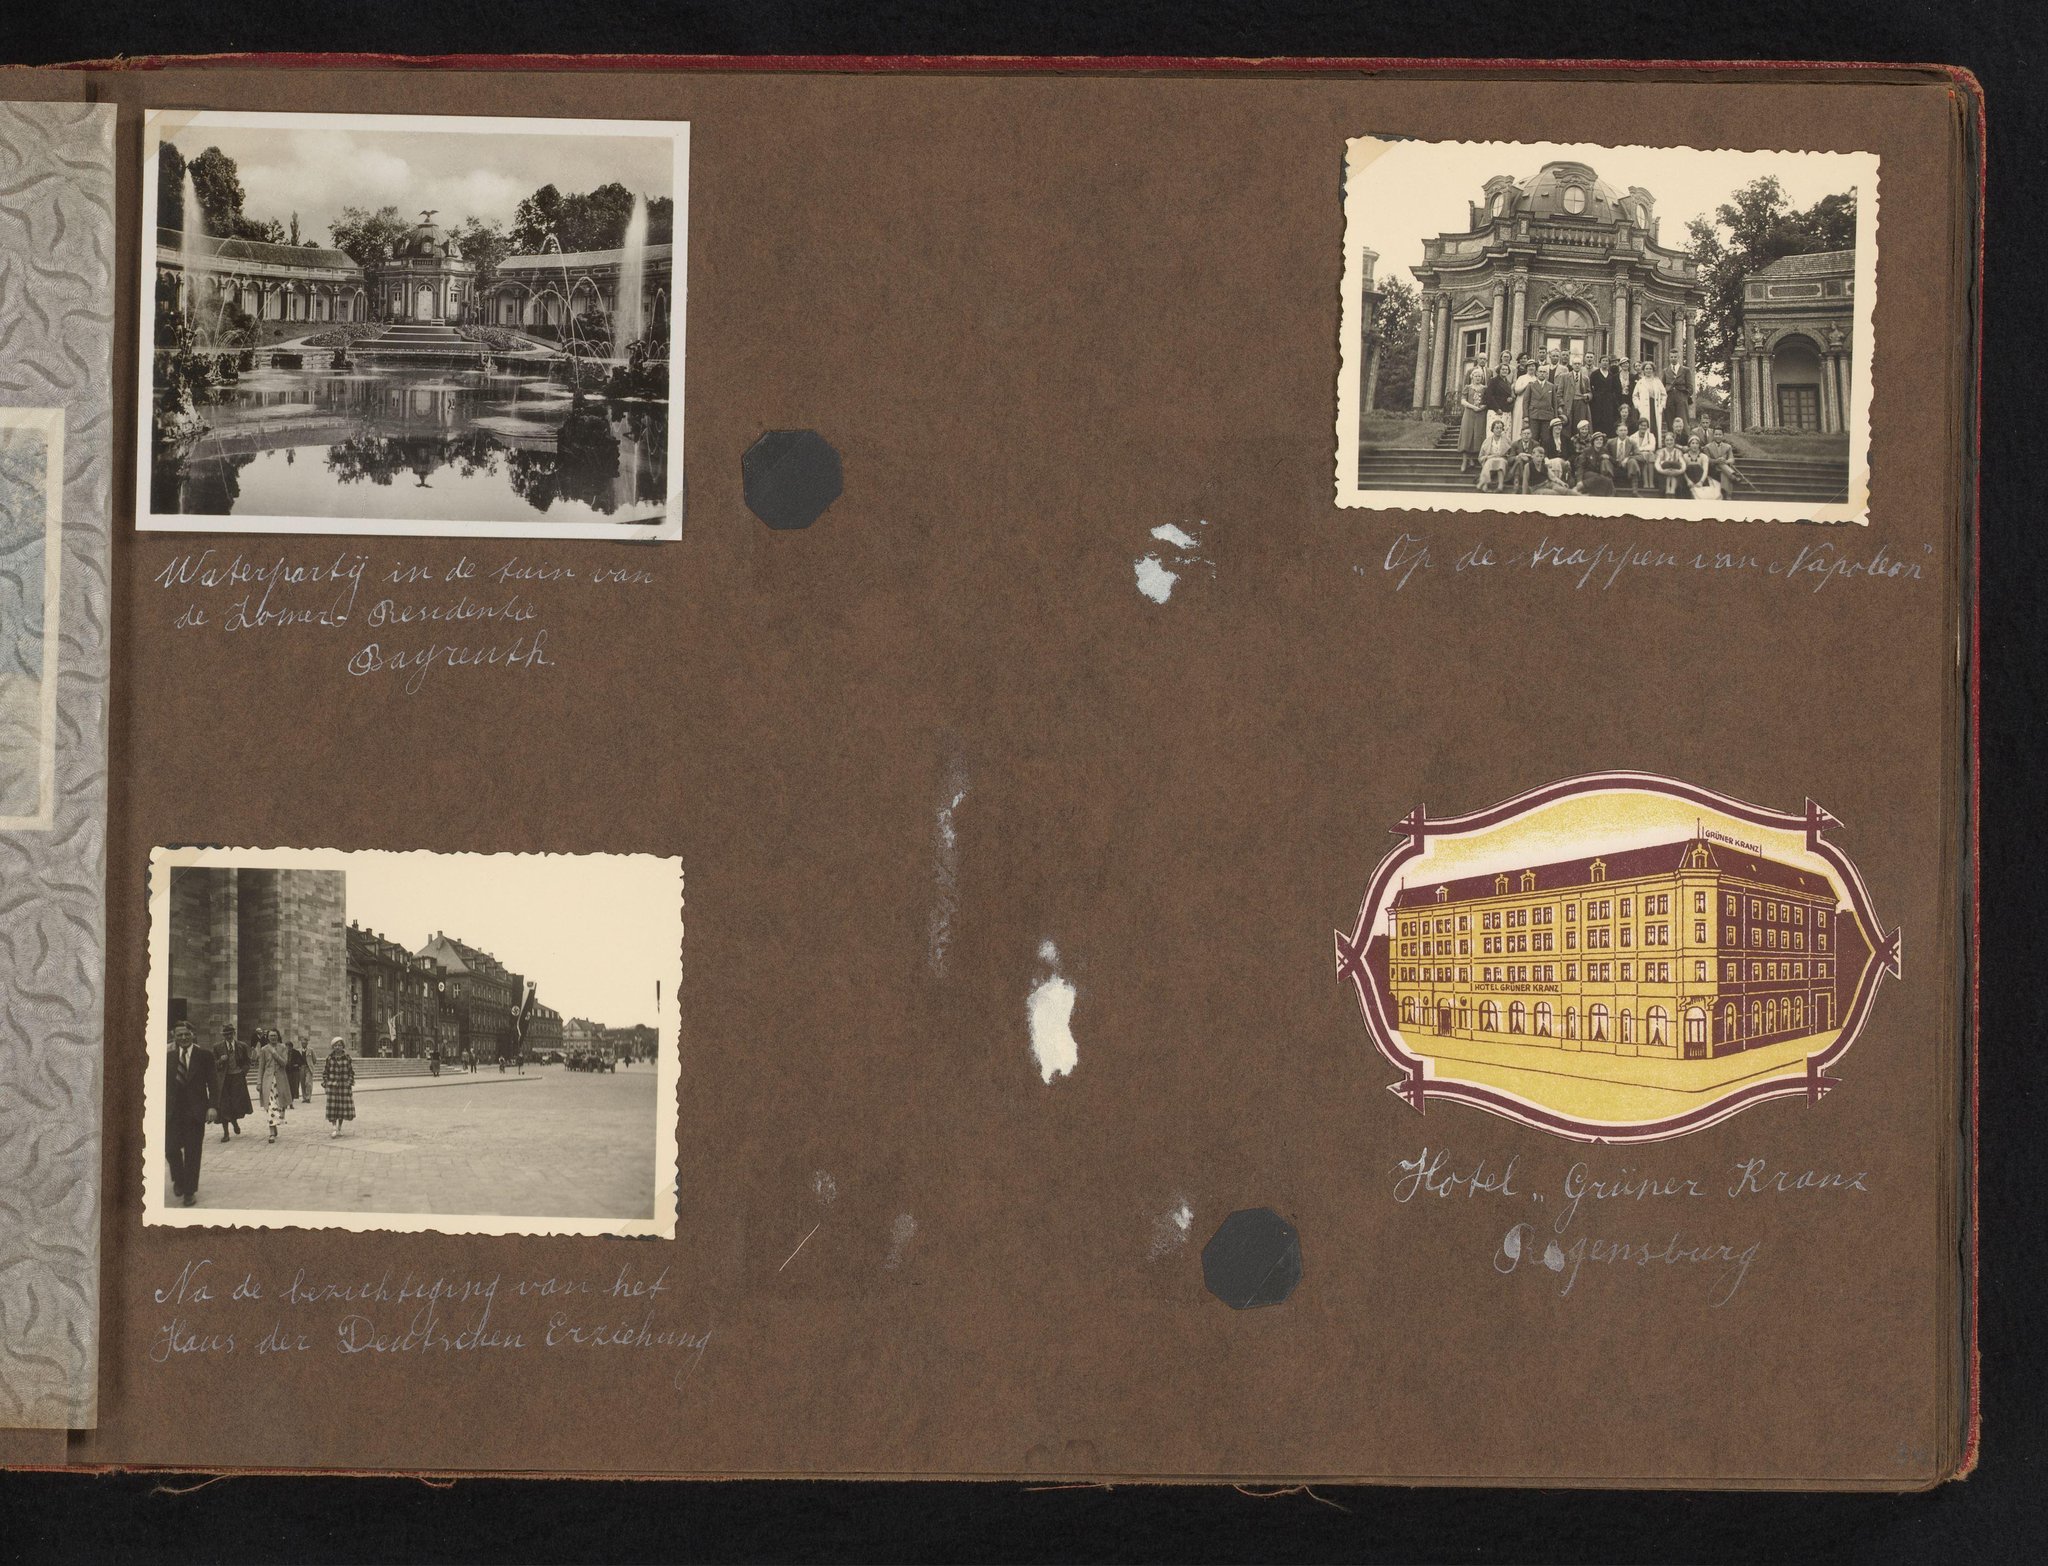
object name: album leaf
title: Bayreuth en Regensburg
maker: Anonymous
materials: paper, photographic support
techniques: gelatin silver print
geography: germany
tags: outing, pleasure trip, germany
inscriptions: inscription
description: Albumblad met drie, deels gekochte, foto's van Bayreuth en een uitgeknipte afbeelding van het hotel in Regensburg. Verslag van een twaalfdaagse groepsreis per autobus naar Salzburgerland en Beieren van 30 juli tot 10 augustus 1936. Onderdeel van het reisalbum van de familie Van den Broek 1935-1937.